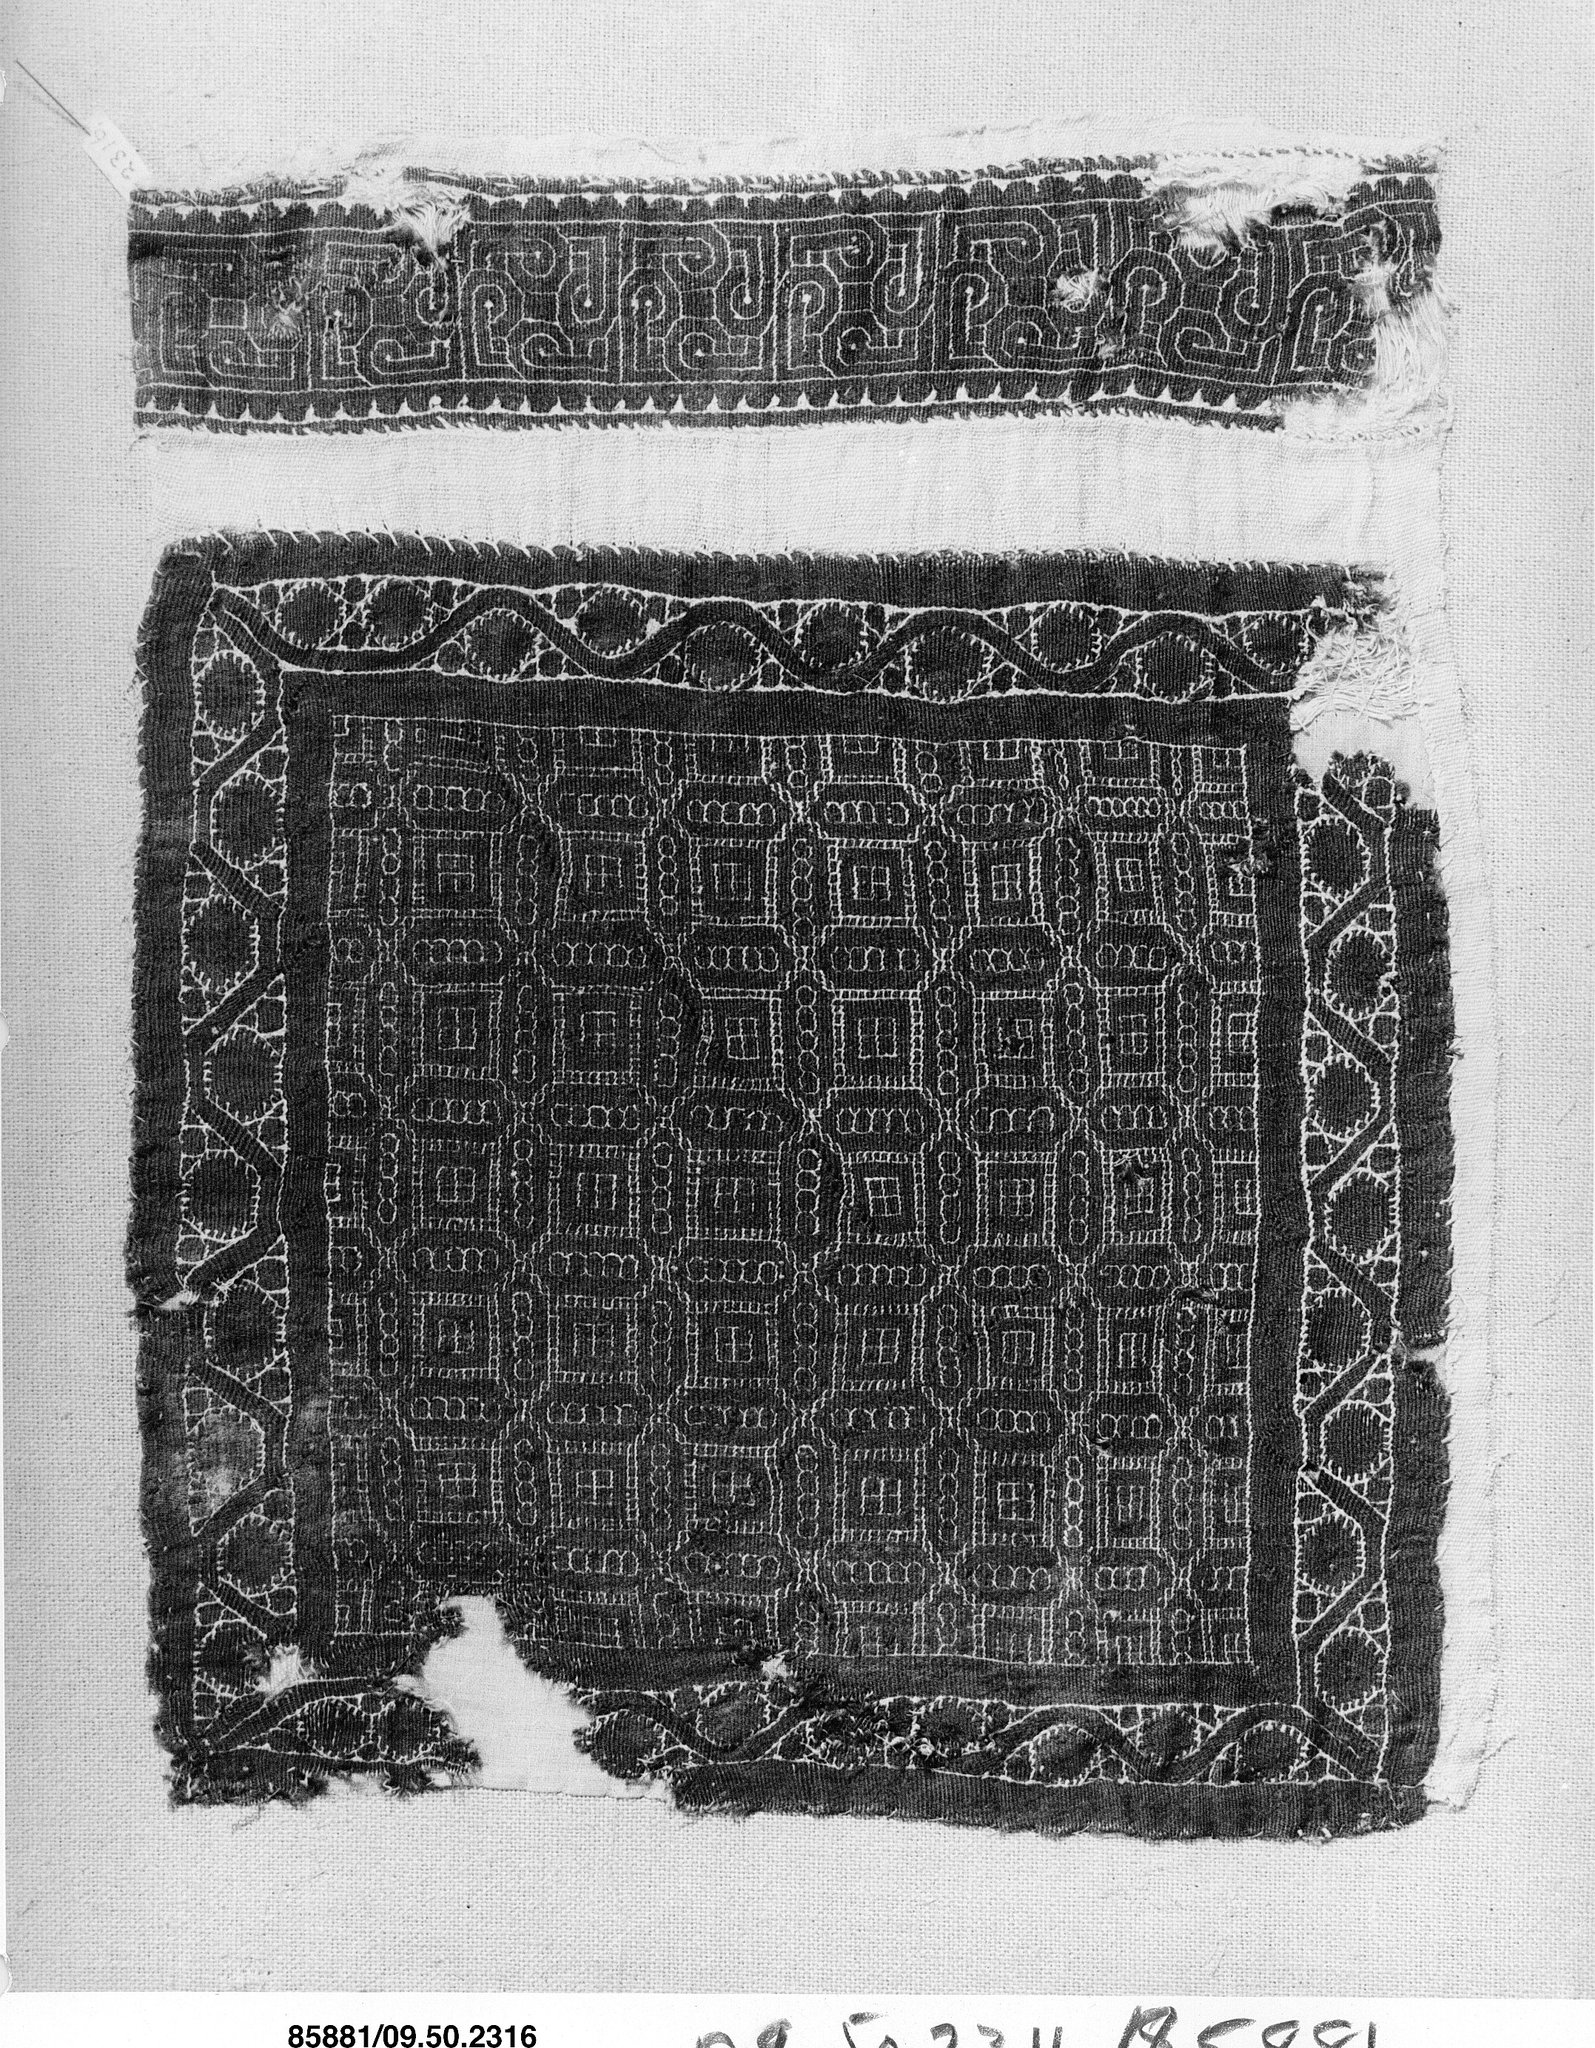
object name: textile fragment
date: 201-400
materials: linen, wool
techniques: weave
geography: egypt